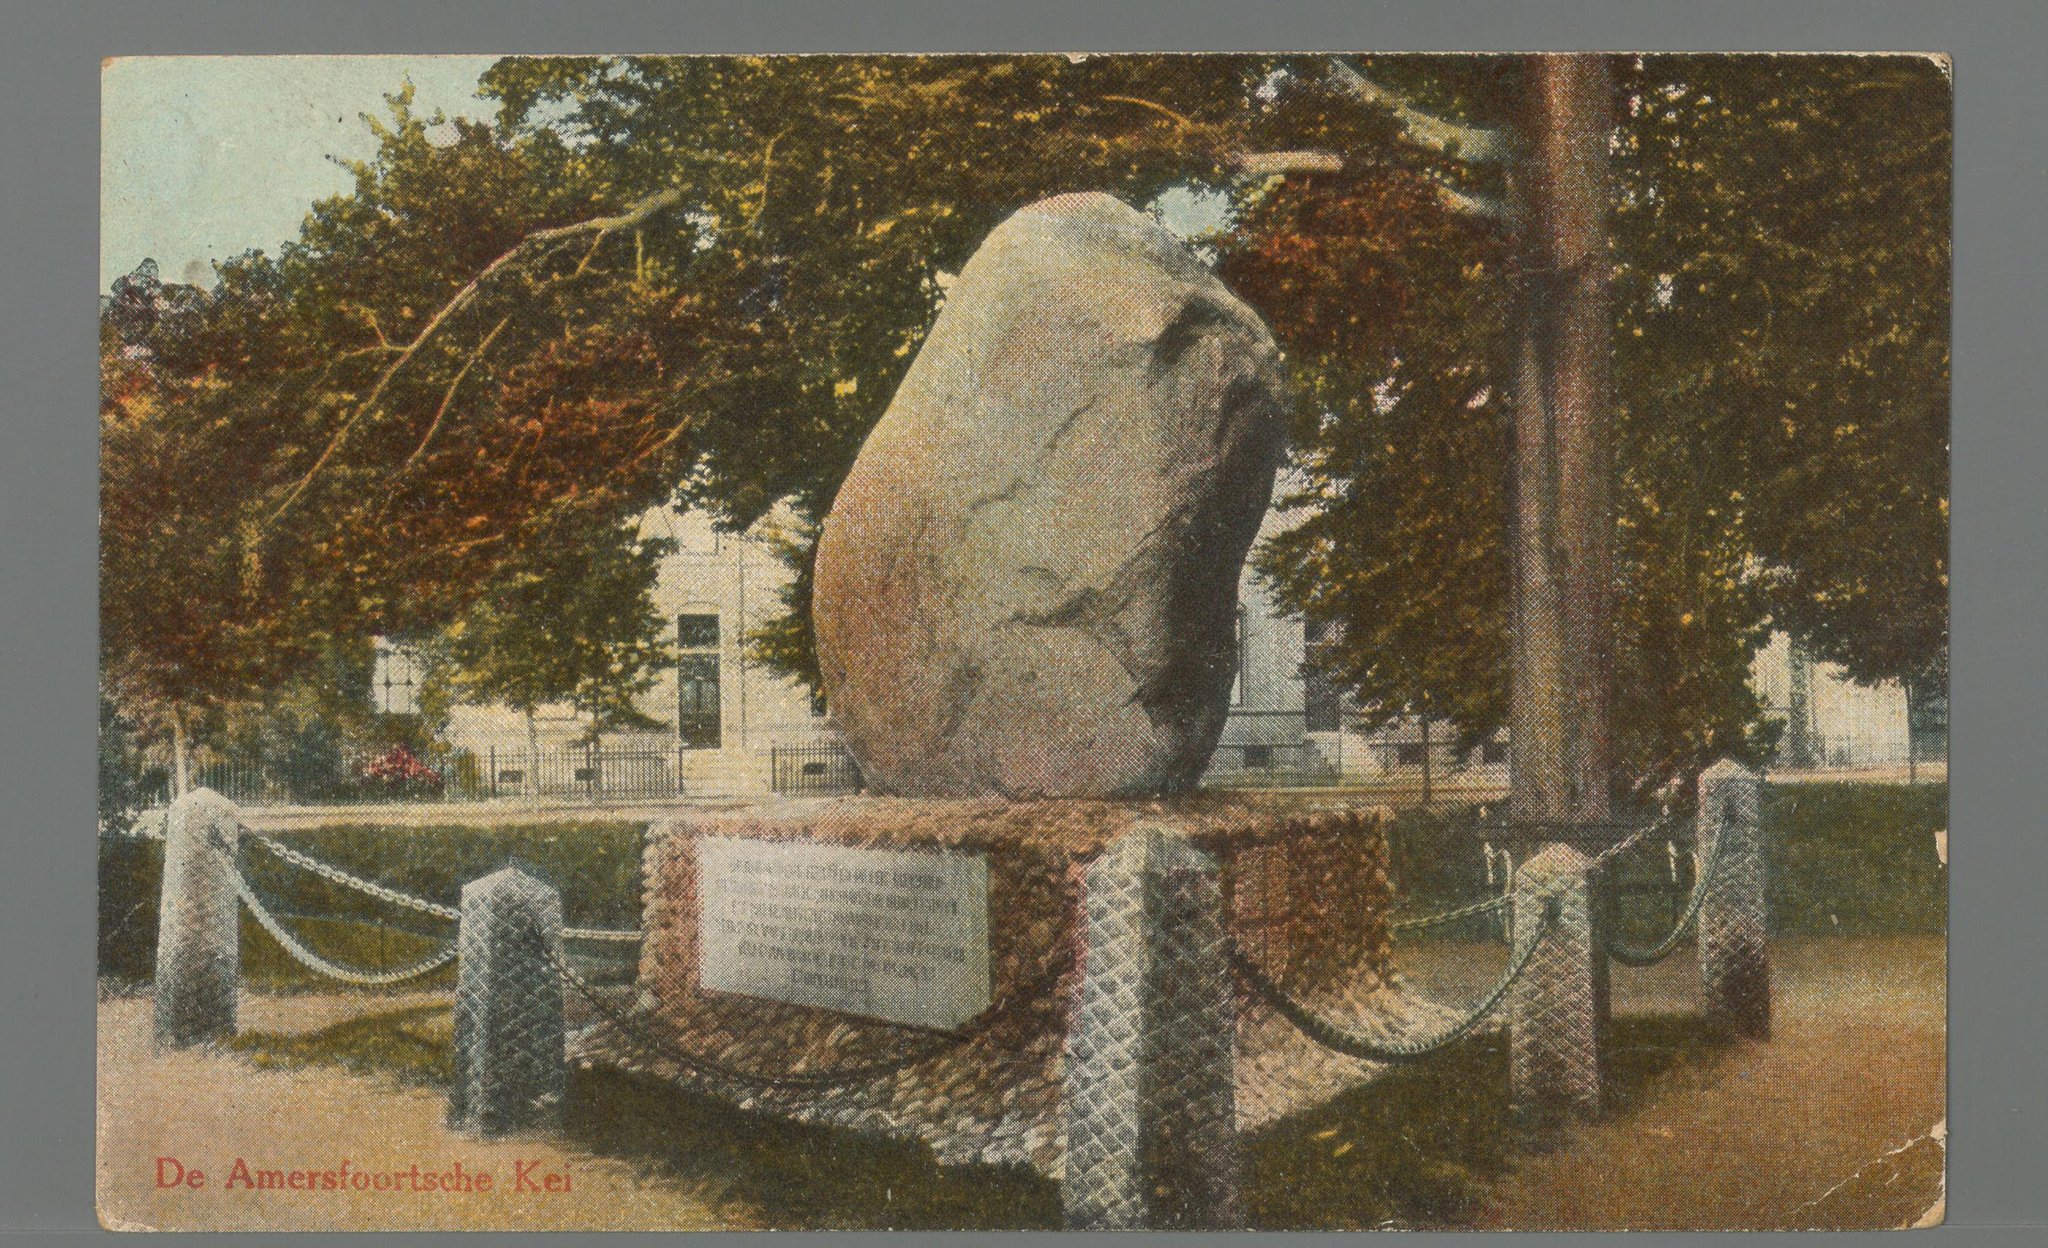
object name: photomechanical print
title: De Amersfoortsche Kei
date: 1918-1927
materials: cardboard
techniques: lithograph, writing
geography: the hague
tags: monument, statue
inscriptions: signature: ‘Uitg. G.B.’